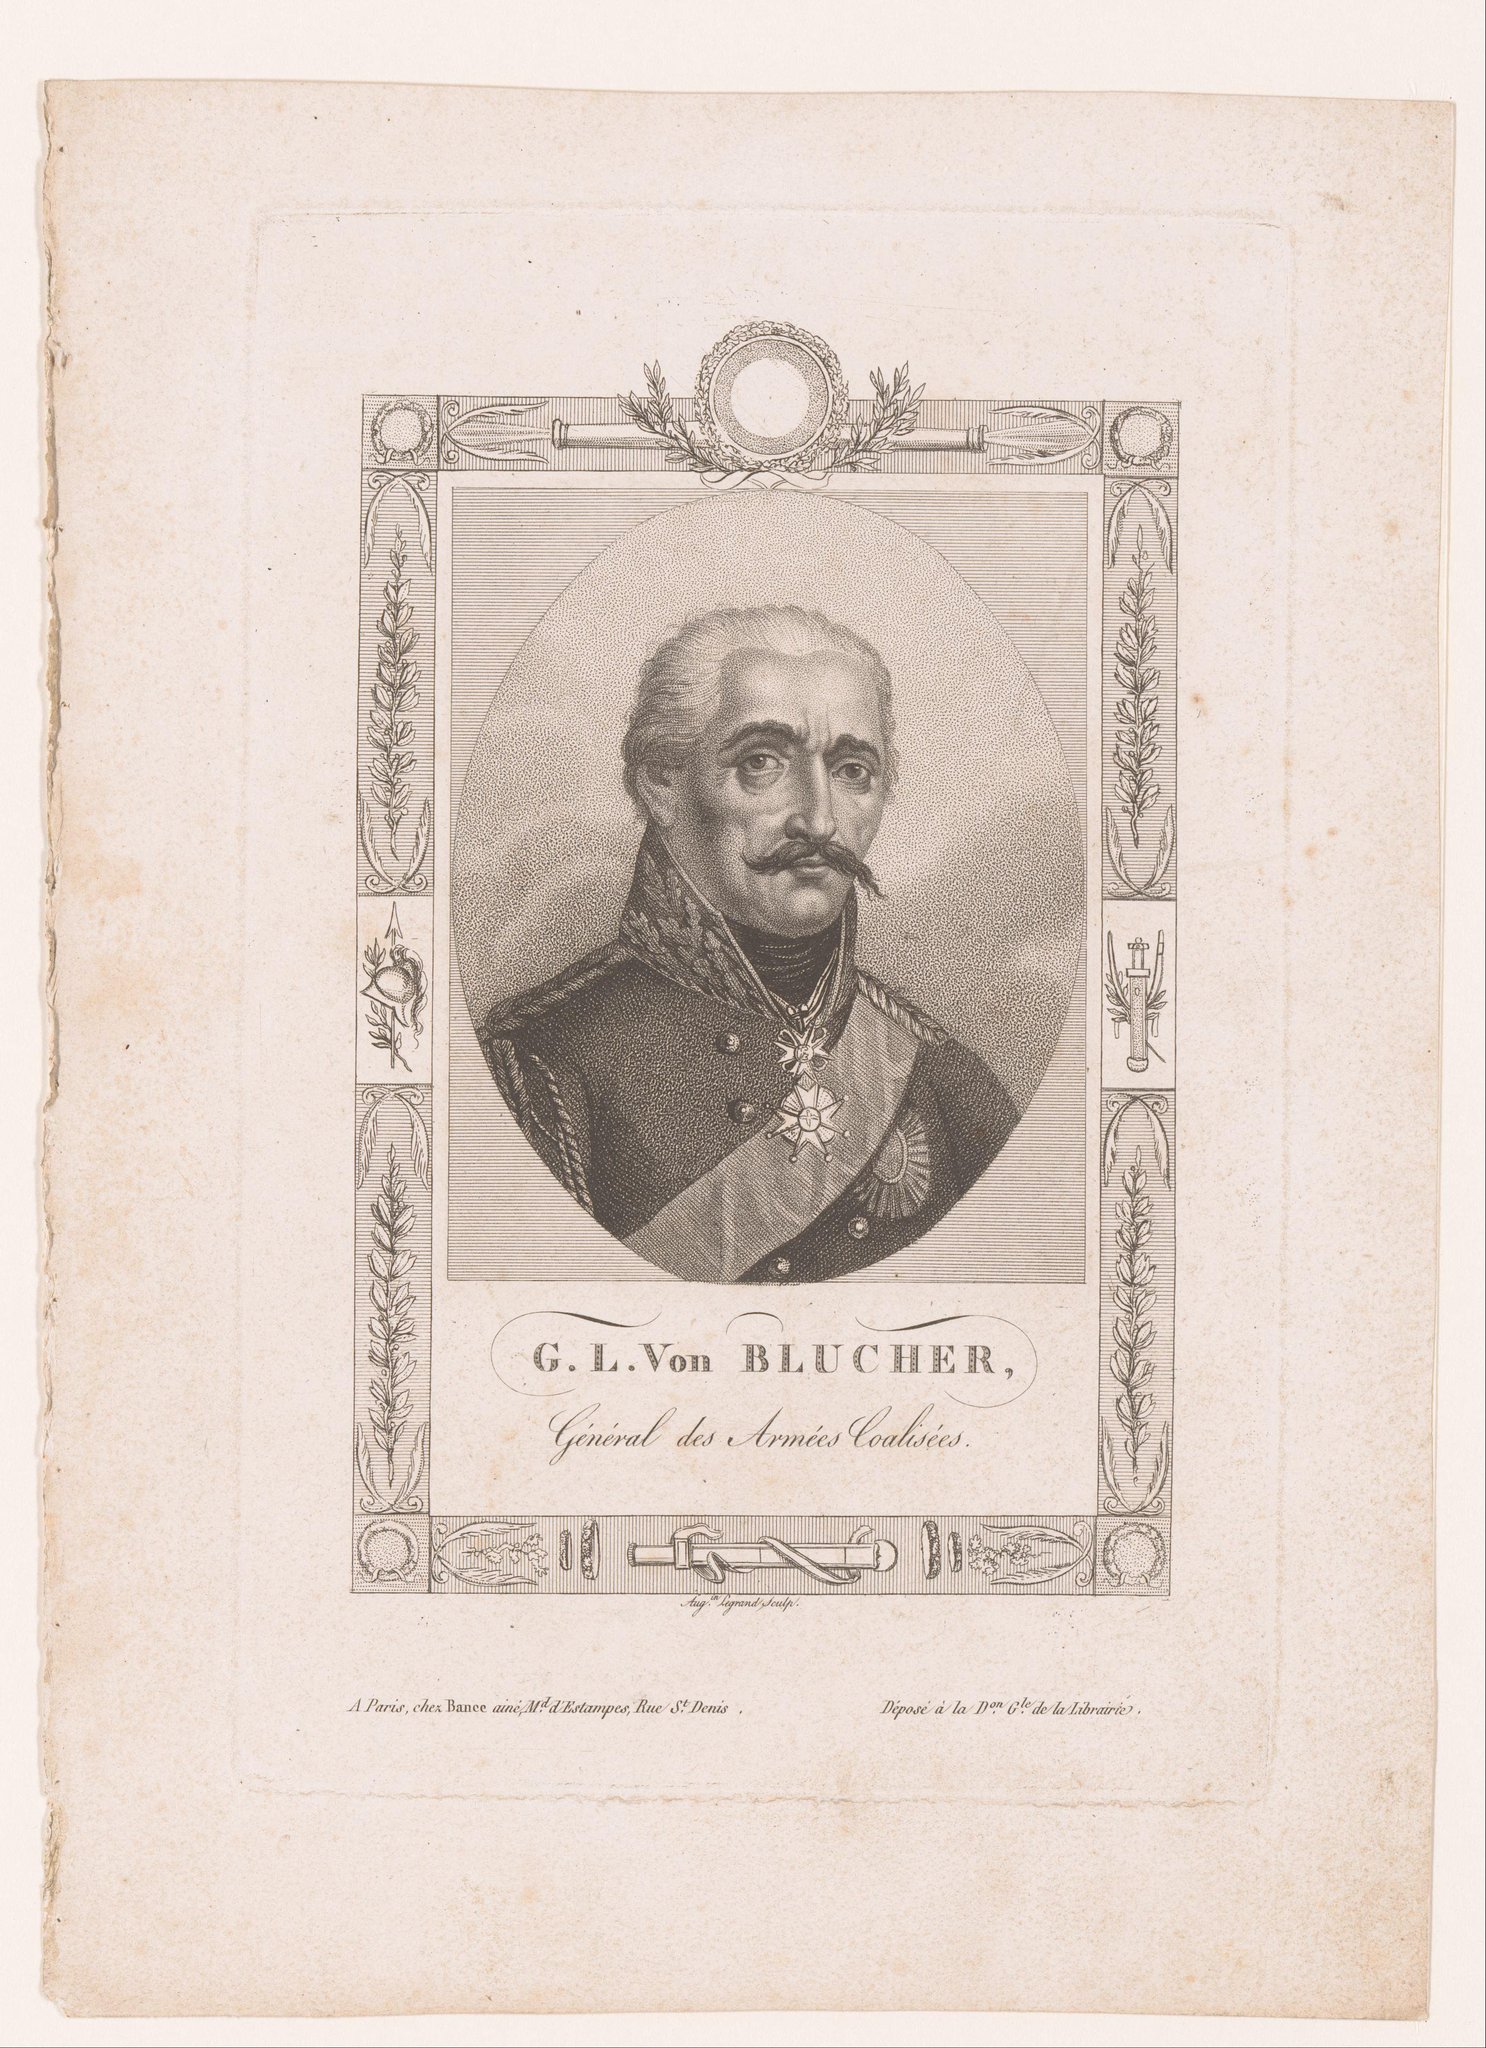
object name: print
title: Portret van Gebhard Leberecht von Blücher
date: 1782-1815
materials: paper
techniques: etching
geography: paris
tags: commander-in-chief, general, marshal, historical persons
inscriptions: : ‘Déposé à la Dom. Gle. de la Librairie.’, collector's mark: Lugt 2228